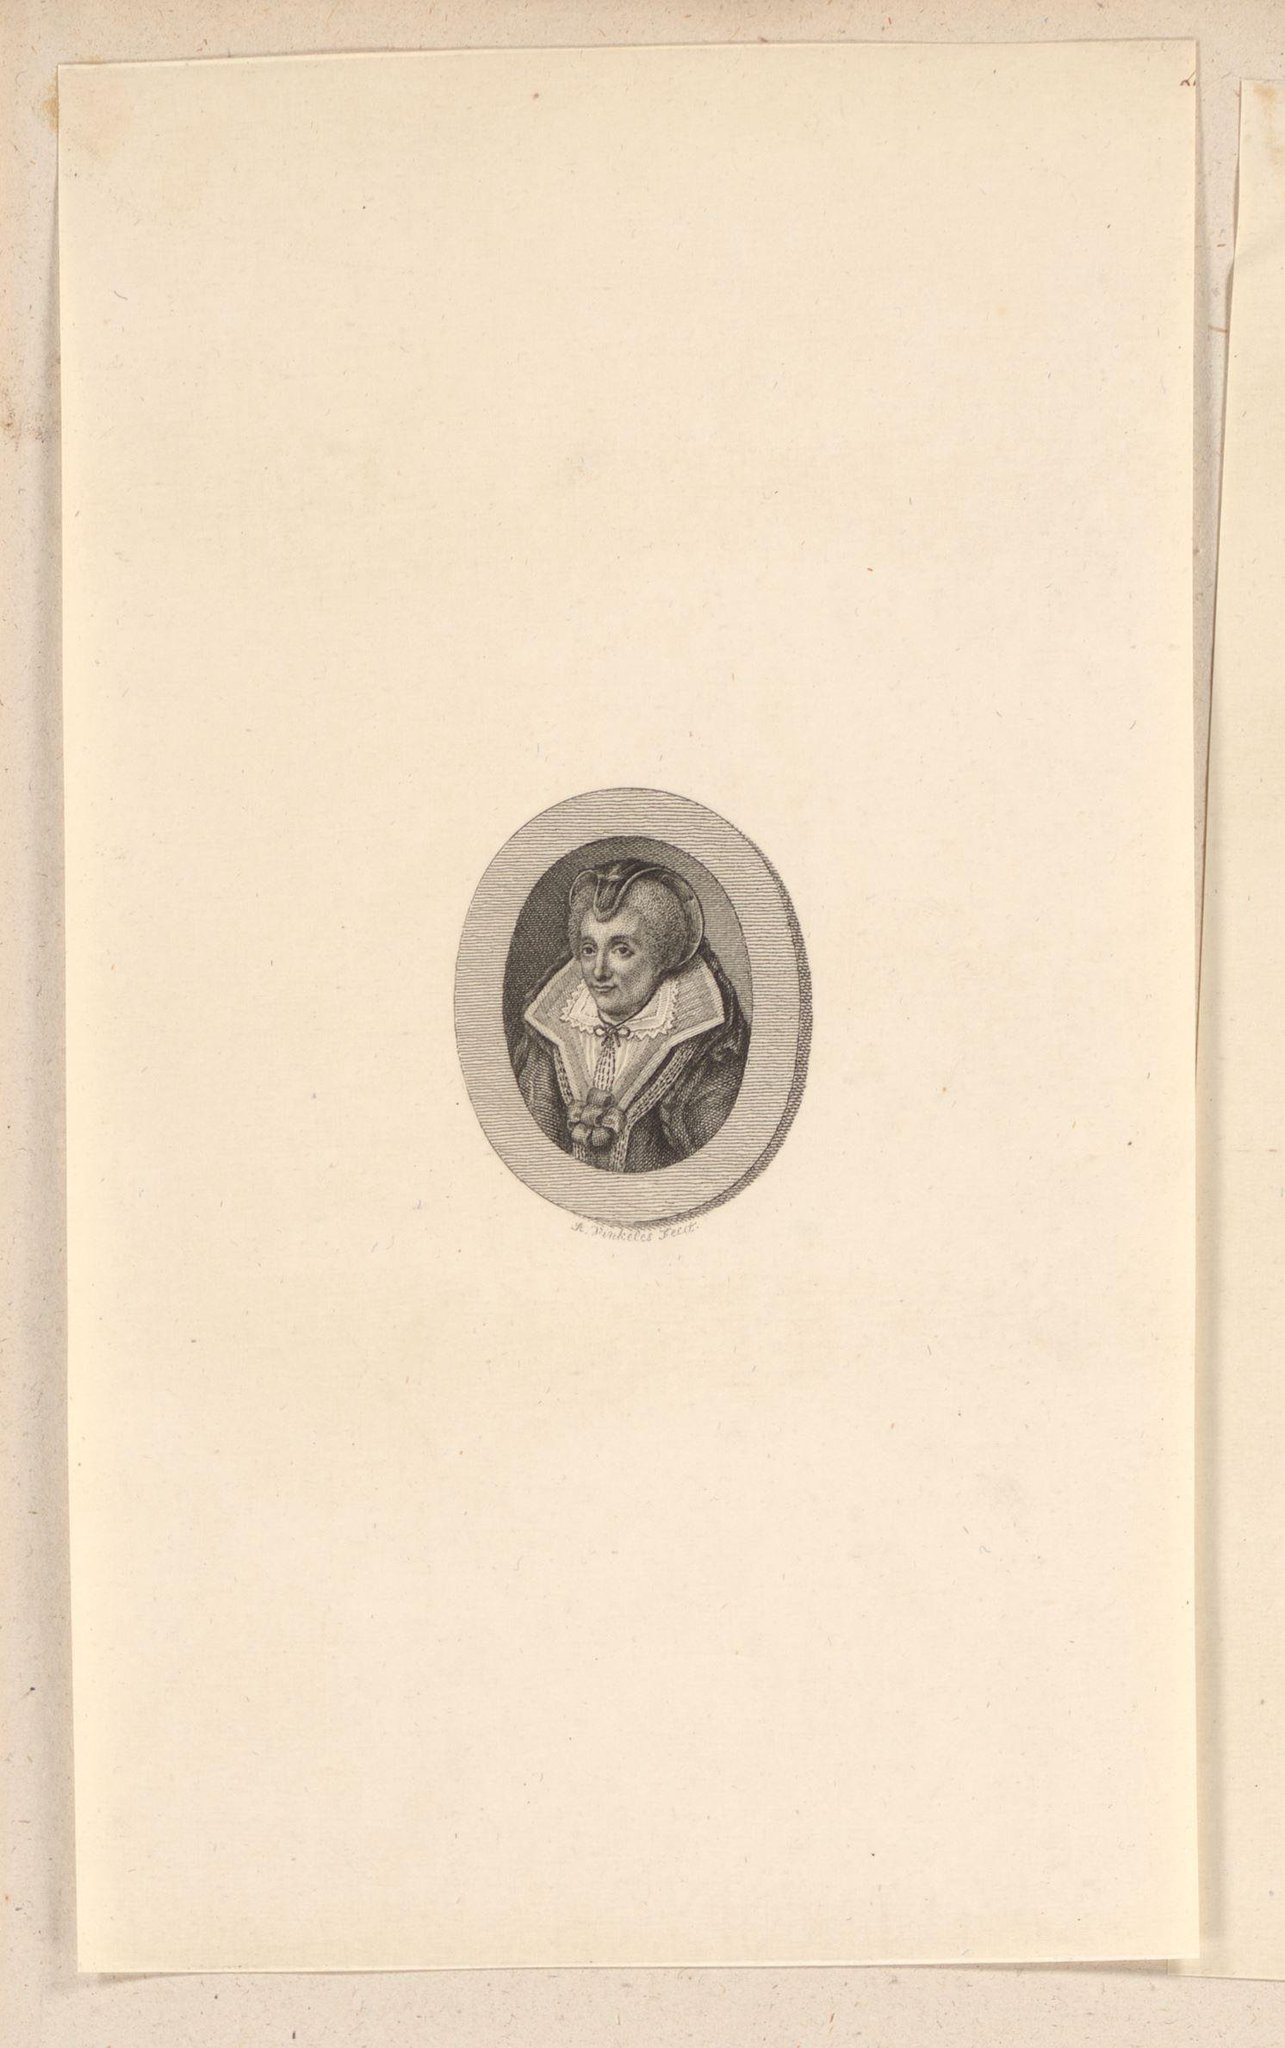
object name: titelblad, titelpagina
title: Portret van Louise de Coligny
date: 1803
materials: paper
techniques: engraving, etching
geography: haarlem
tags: louise de coligny, neck-gear: collar (+ women's clothes)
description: Proefdruk van een titelpagina gebruikt voor: Loosjes Pietersz., Adriaan. Louise de Cologny. Haarlem: A. Loosjes, 1803.